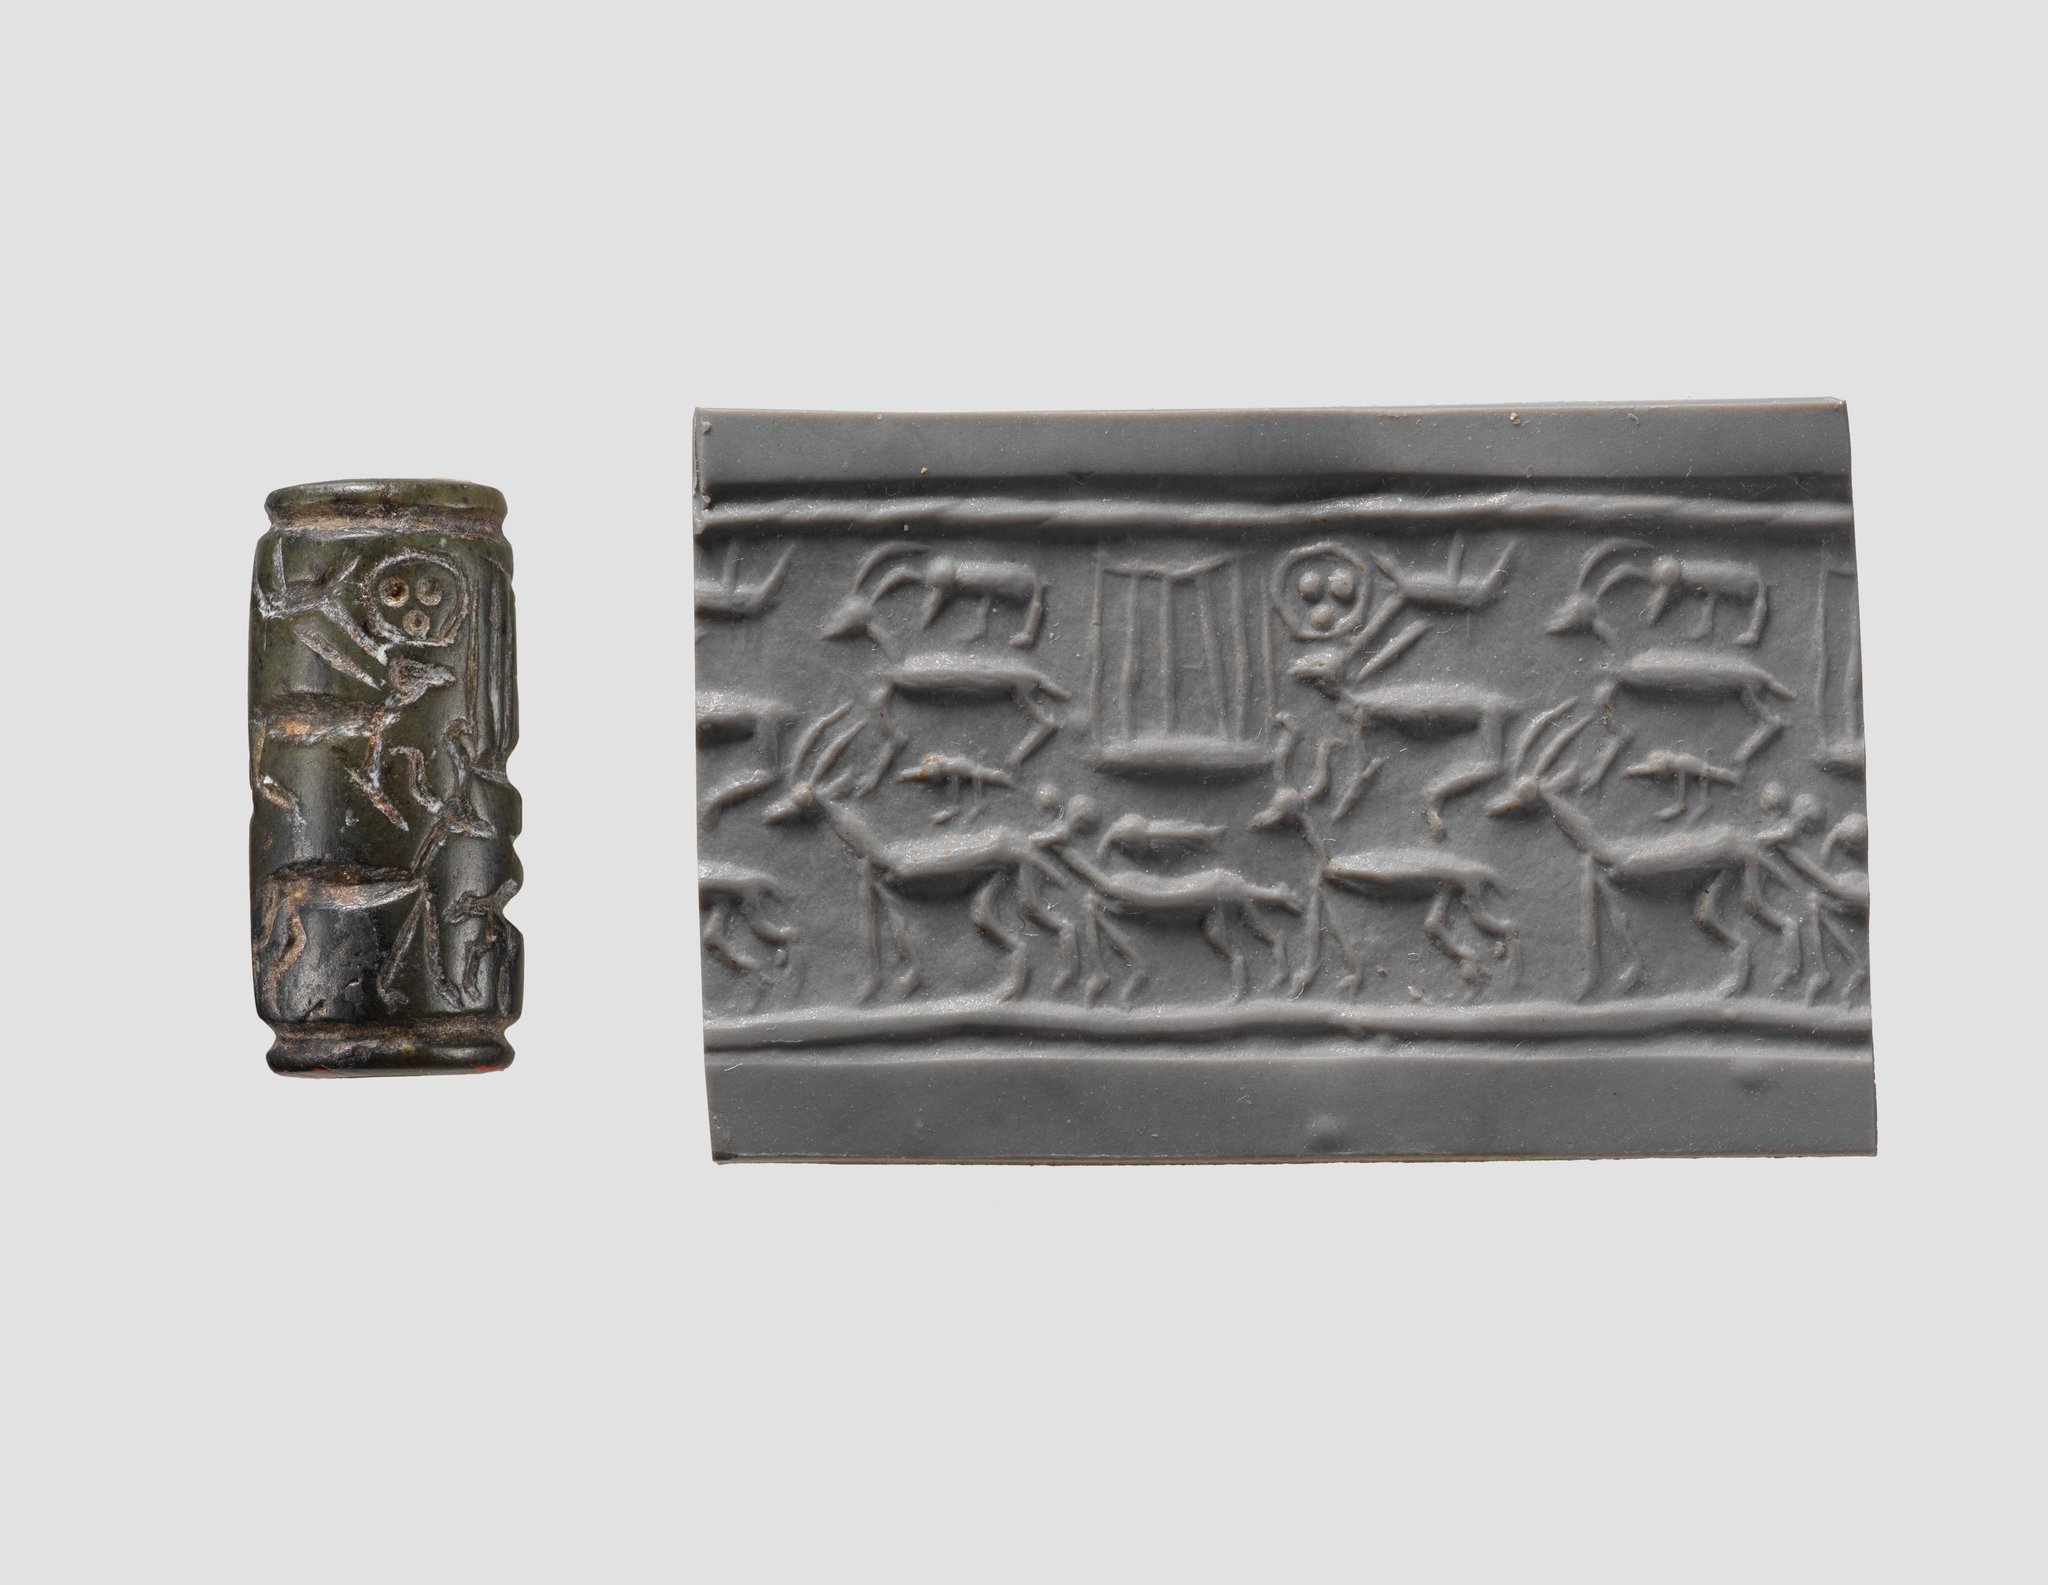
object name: cylinder seal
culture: mitanni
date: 1500-1201 BCE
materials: quartz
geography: mesopotamia or syria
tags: animals